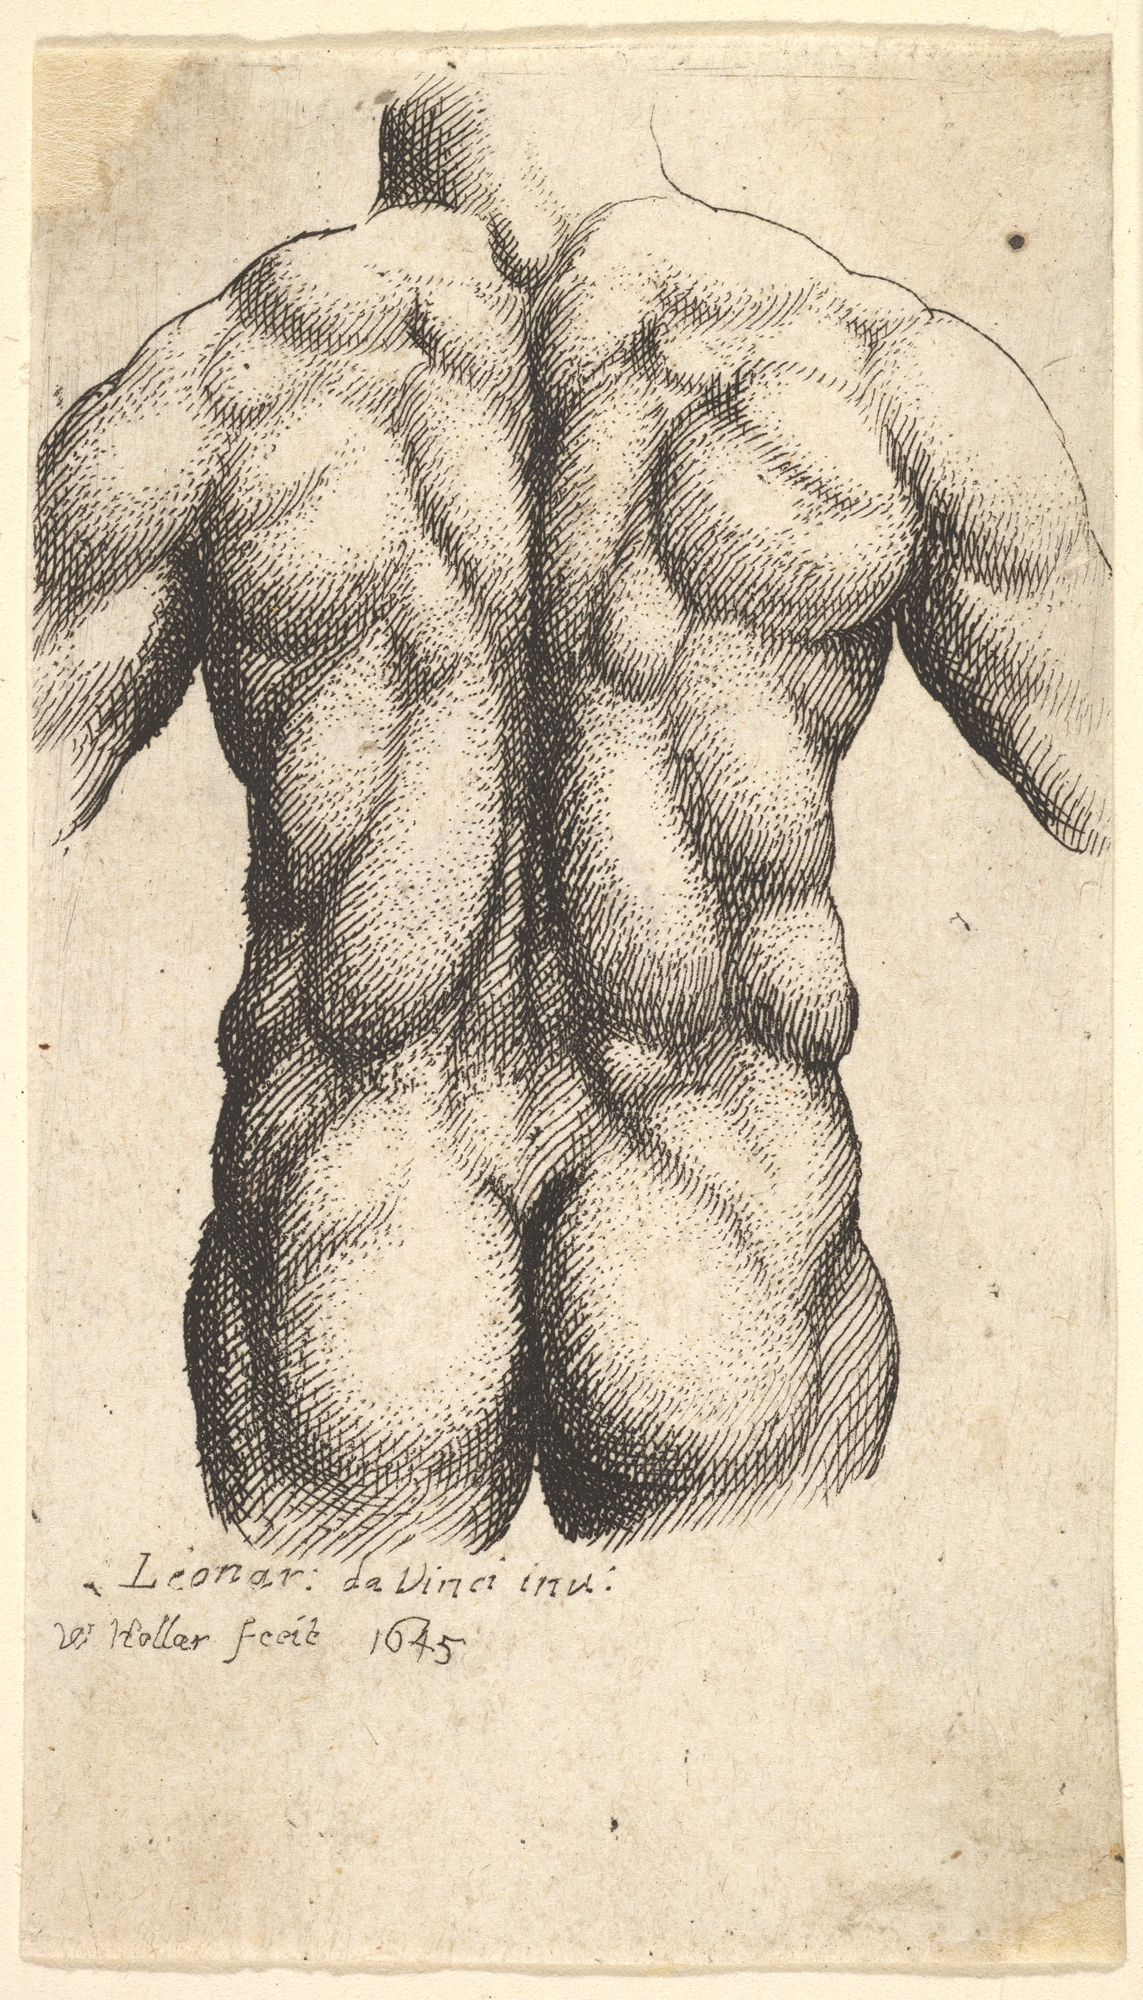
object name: print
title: Naked male torso seen from behind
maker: wenceslaus hollar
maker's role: artist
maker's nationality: bohemian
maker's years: 1607-1677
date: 1645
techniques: etching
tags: male nudes